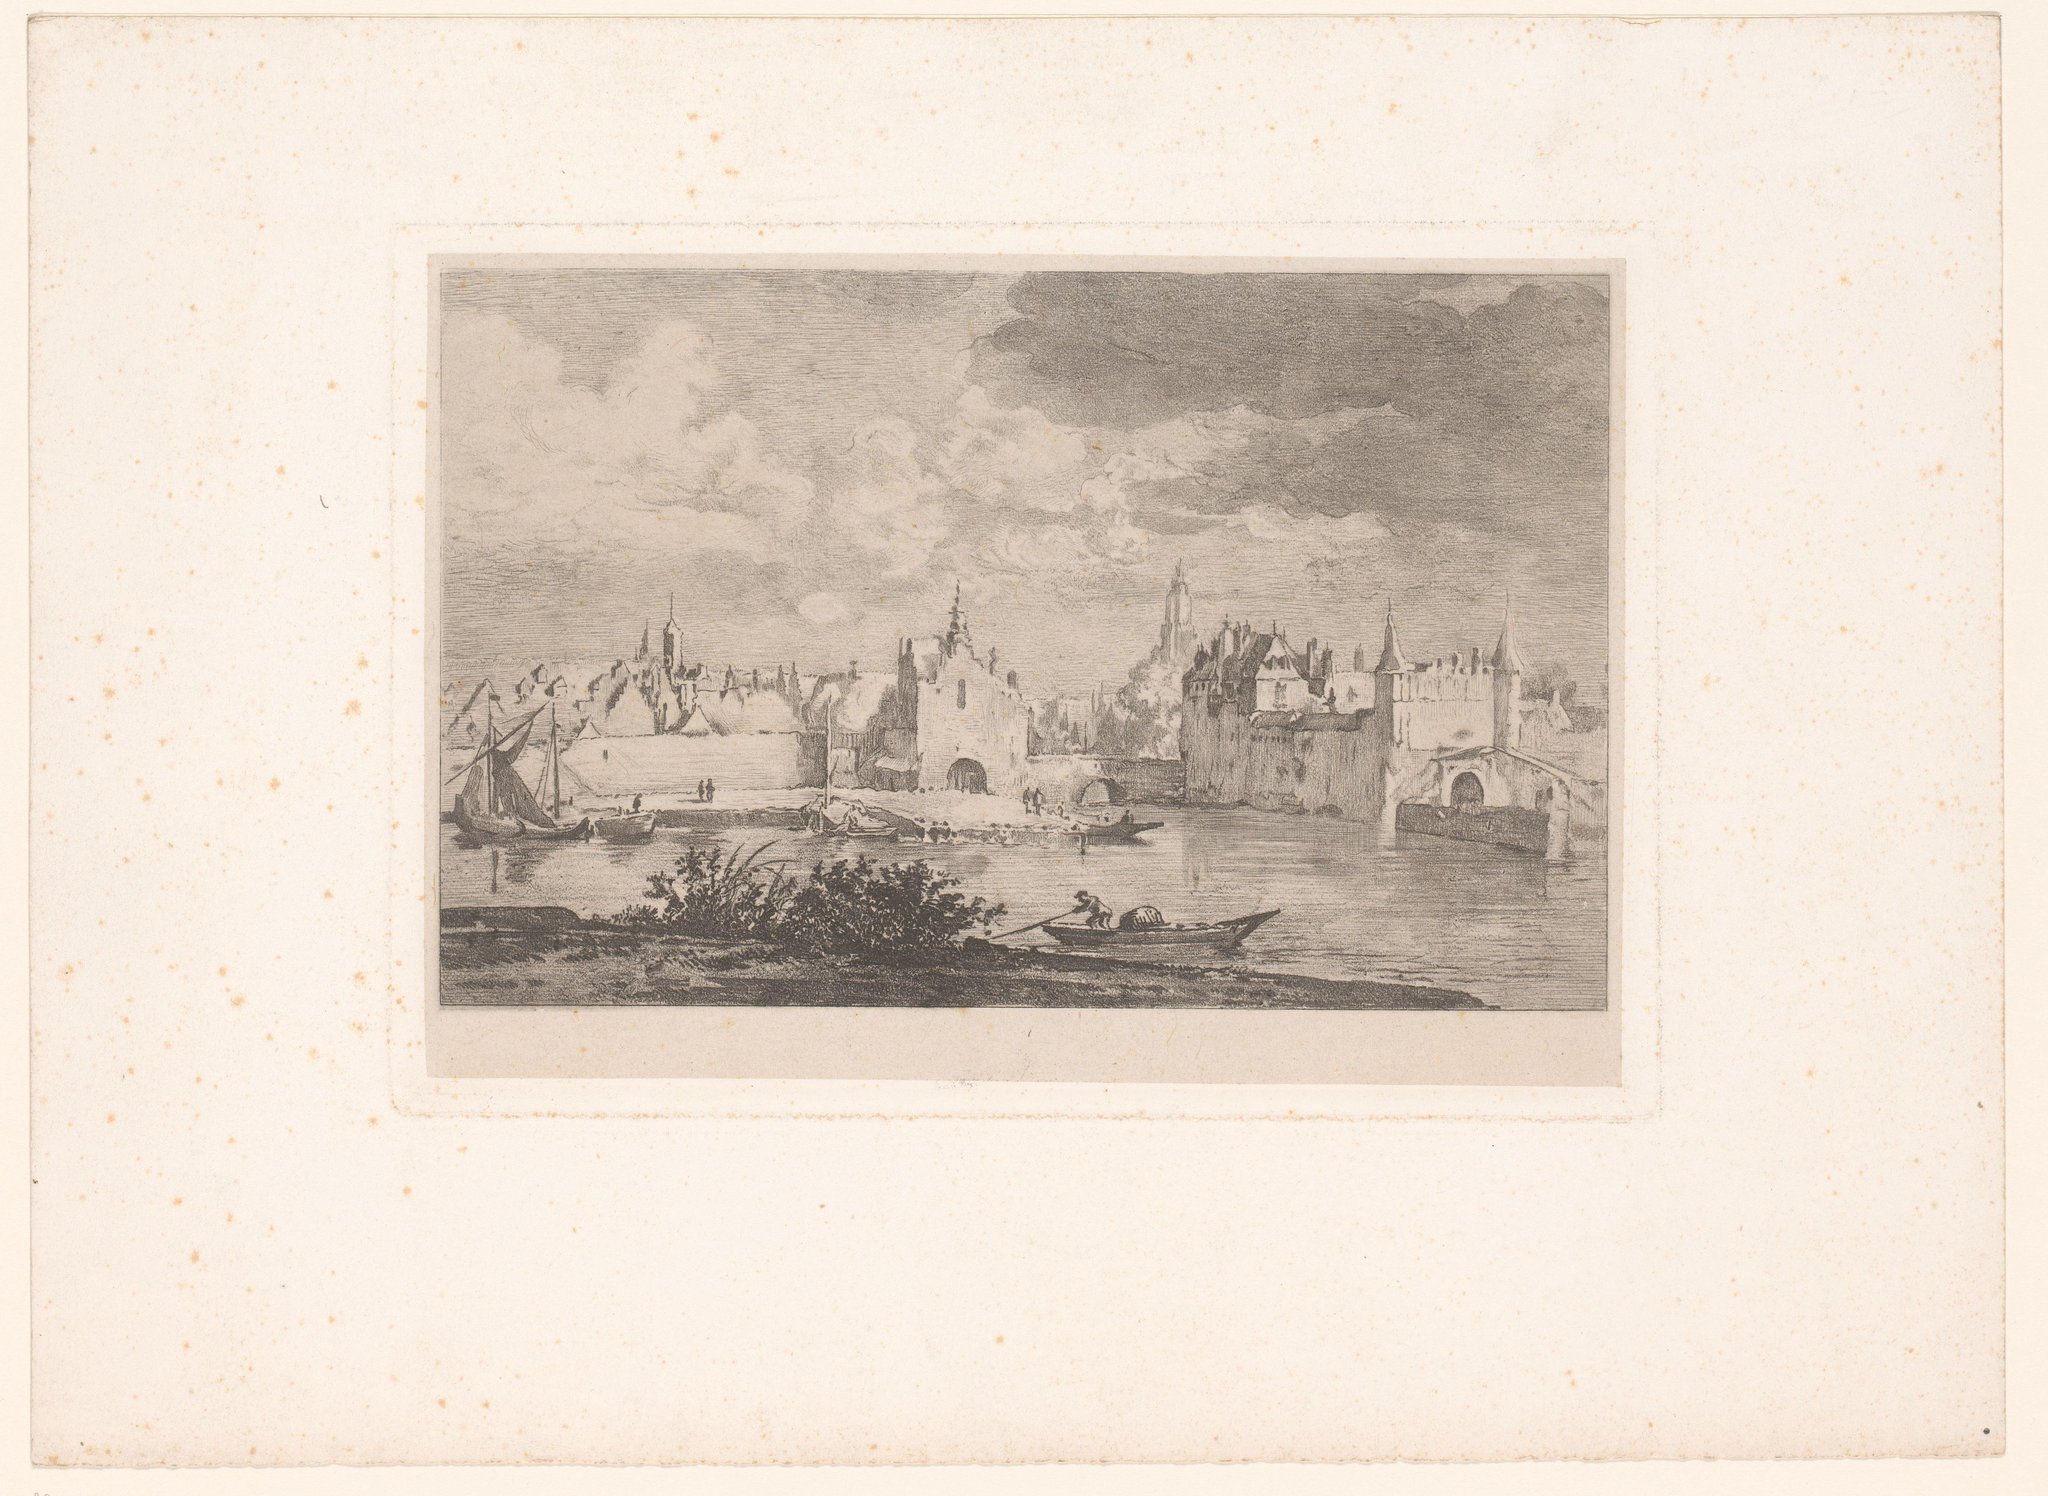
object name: print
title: Gezicht op Delft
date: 1837-1886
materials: paper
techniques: soft ground etching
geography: france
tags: city-view, and landscape with man-made constructions - ii - ideal landscapes, landscapes with waters, waterscapes, seascapes (in the temperate zone), delft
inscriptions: collector's mark: Lugt 2228